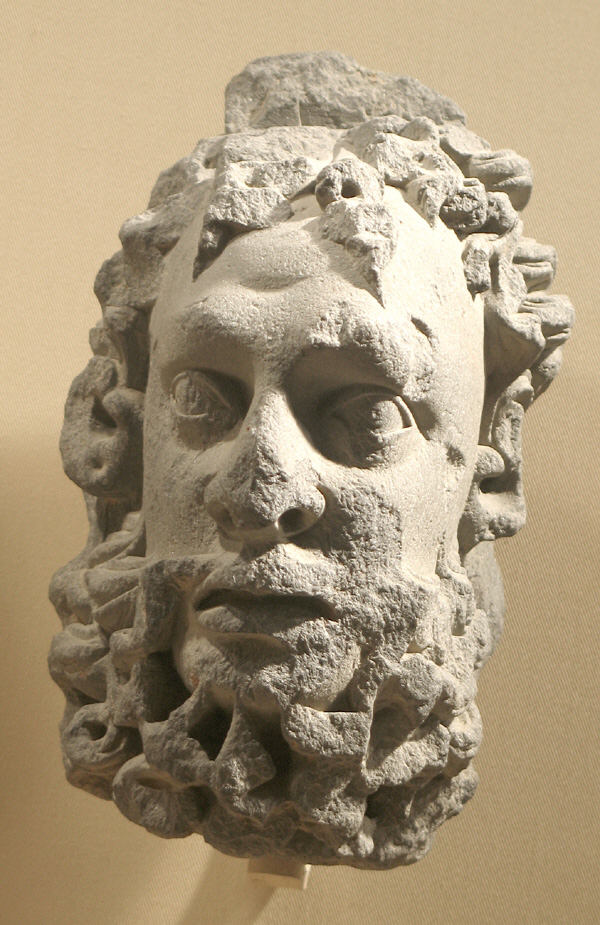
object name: head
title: Head of a Bearded Male Figure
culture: gandhara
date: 201-300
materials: stone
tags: gandhara,heads,men